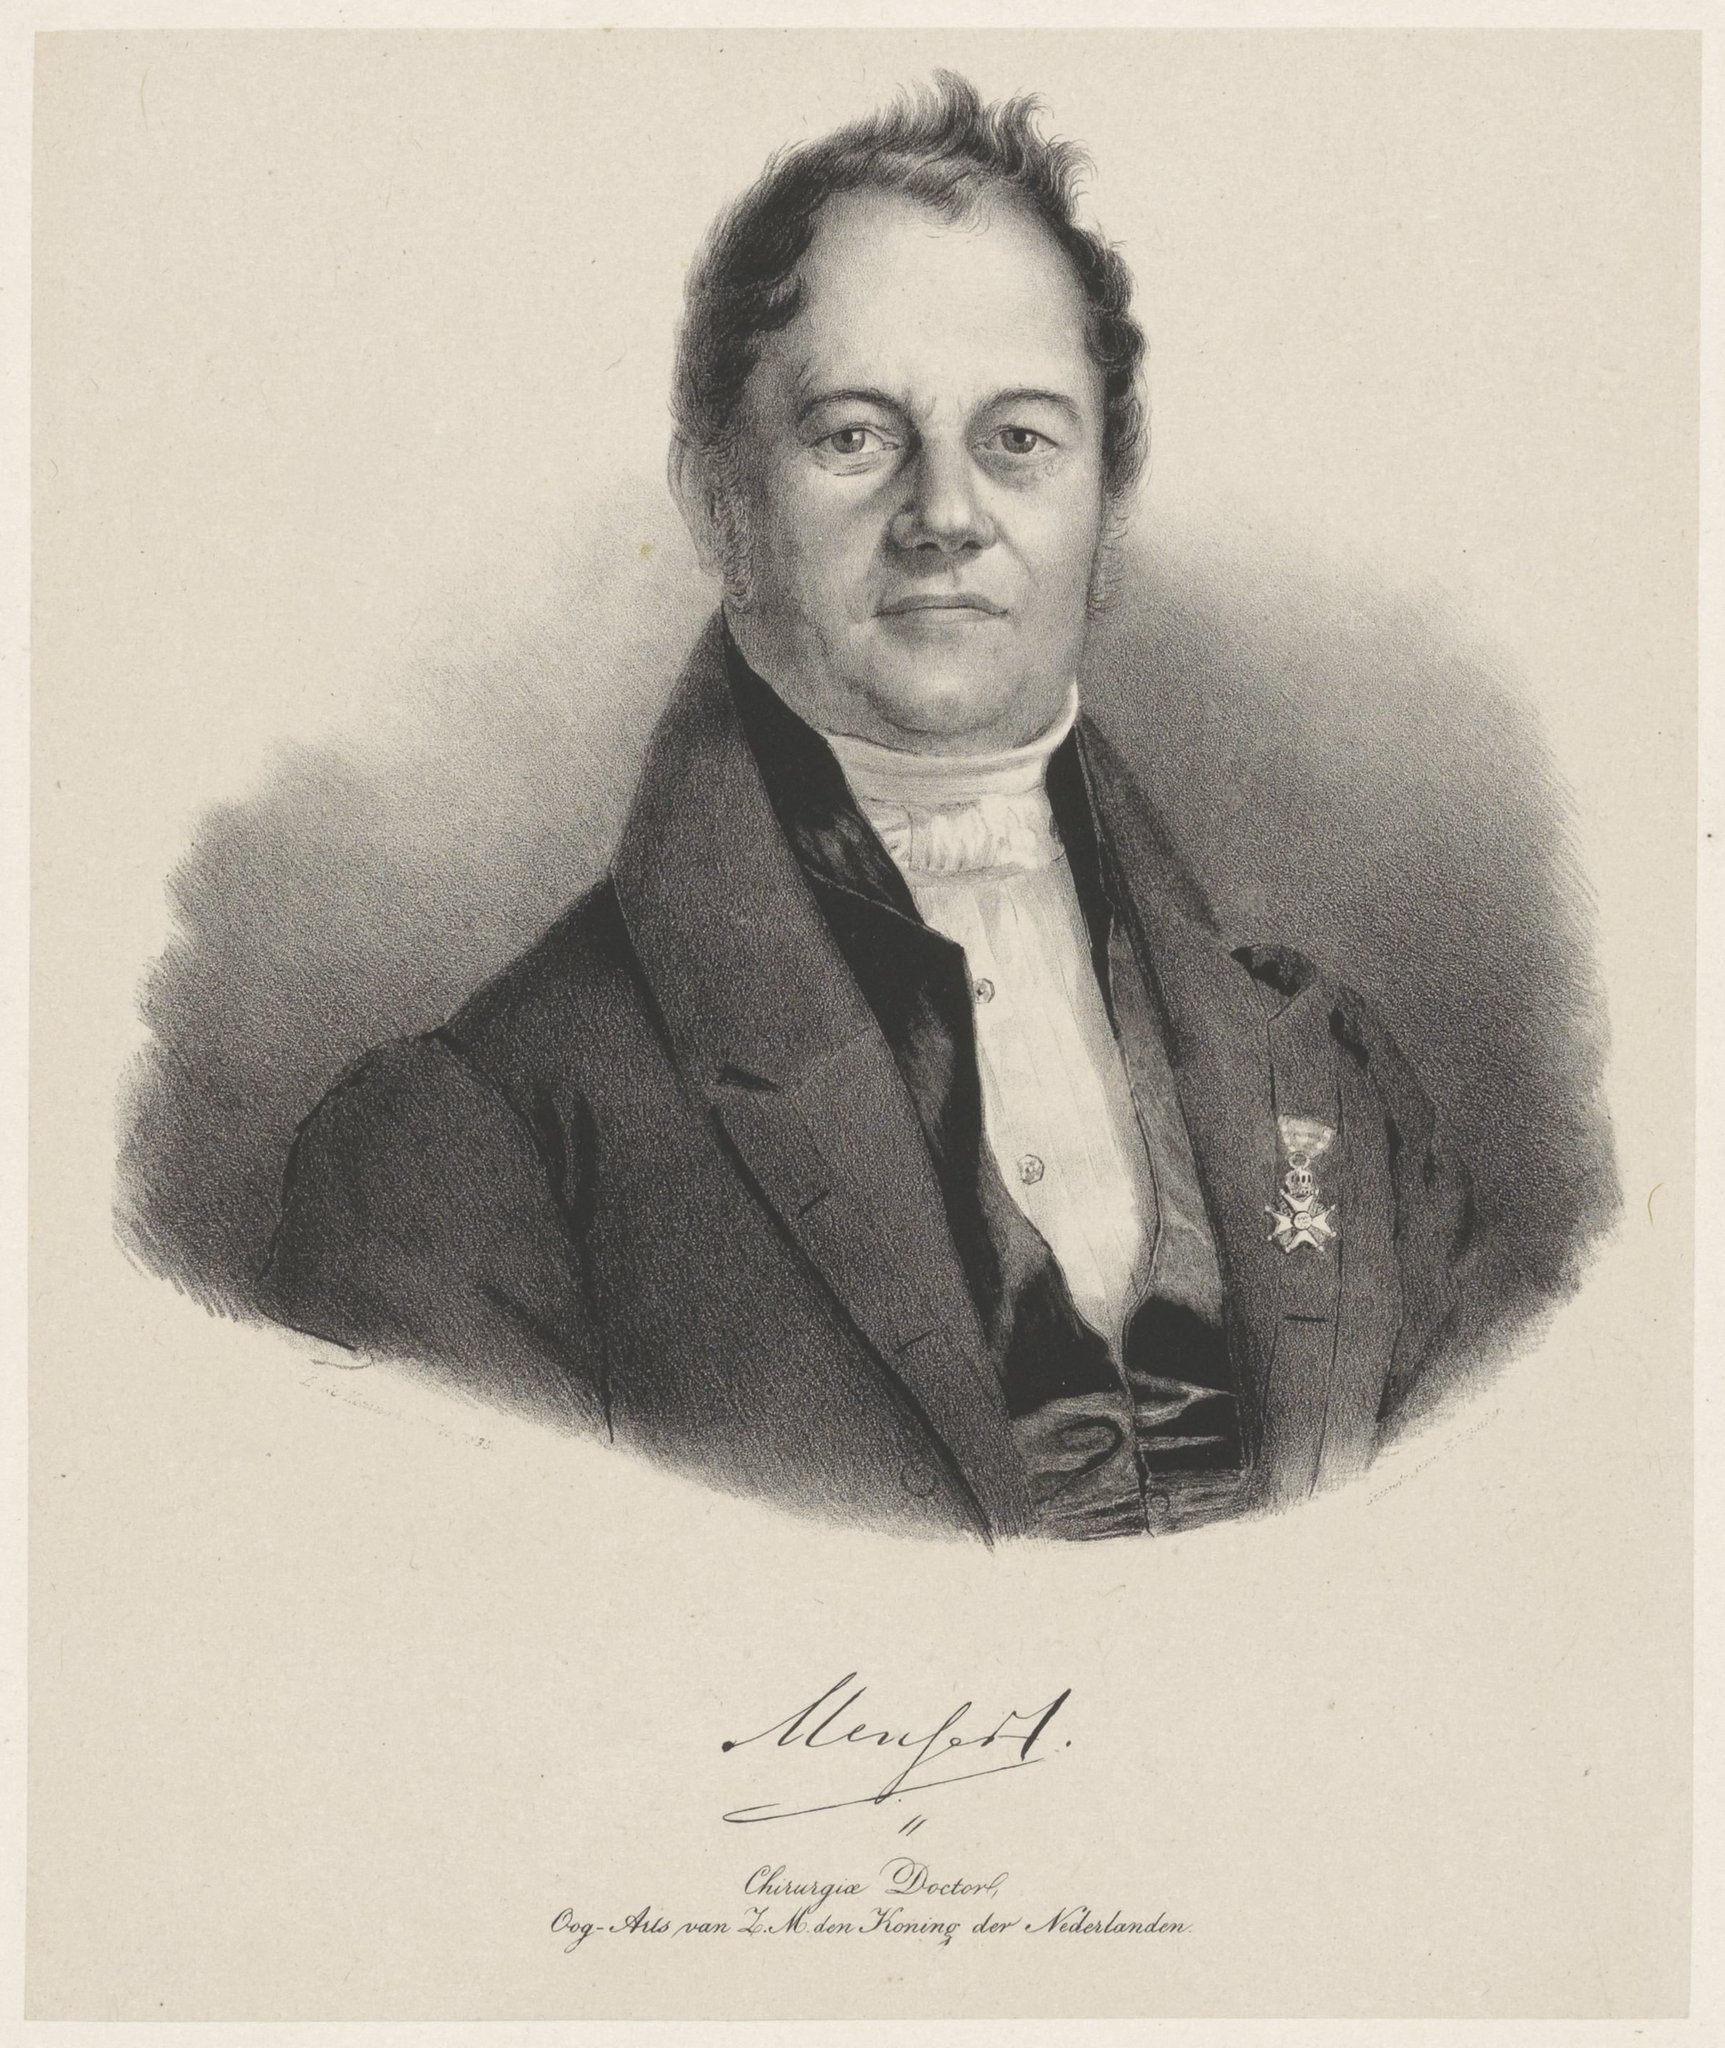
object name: print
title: Portret van Willem Mensert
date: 1835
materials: paper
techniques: lithograph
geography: dordrecht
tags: amsterdam, knighthood order, historical persons (+ (full) bust portrait)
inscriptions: collector's mark: Lugt 2228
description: De geportretteerde draagt een ridderorde op de revers van zijn jas. Onder het portret zijn signatuur.